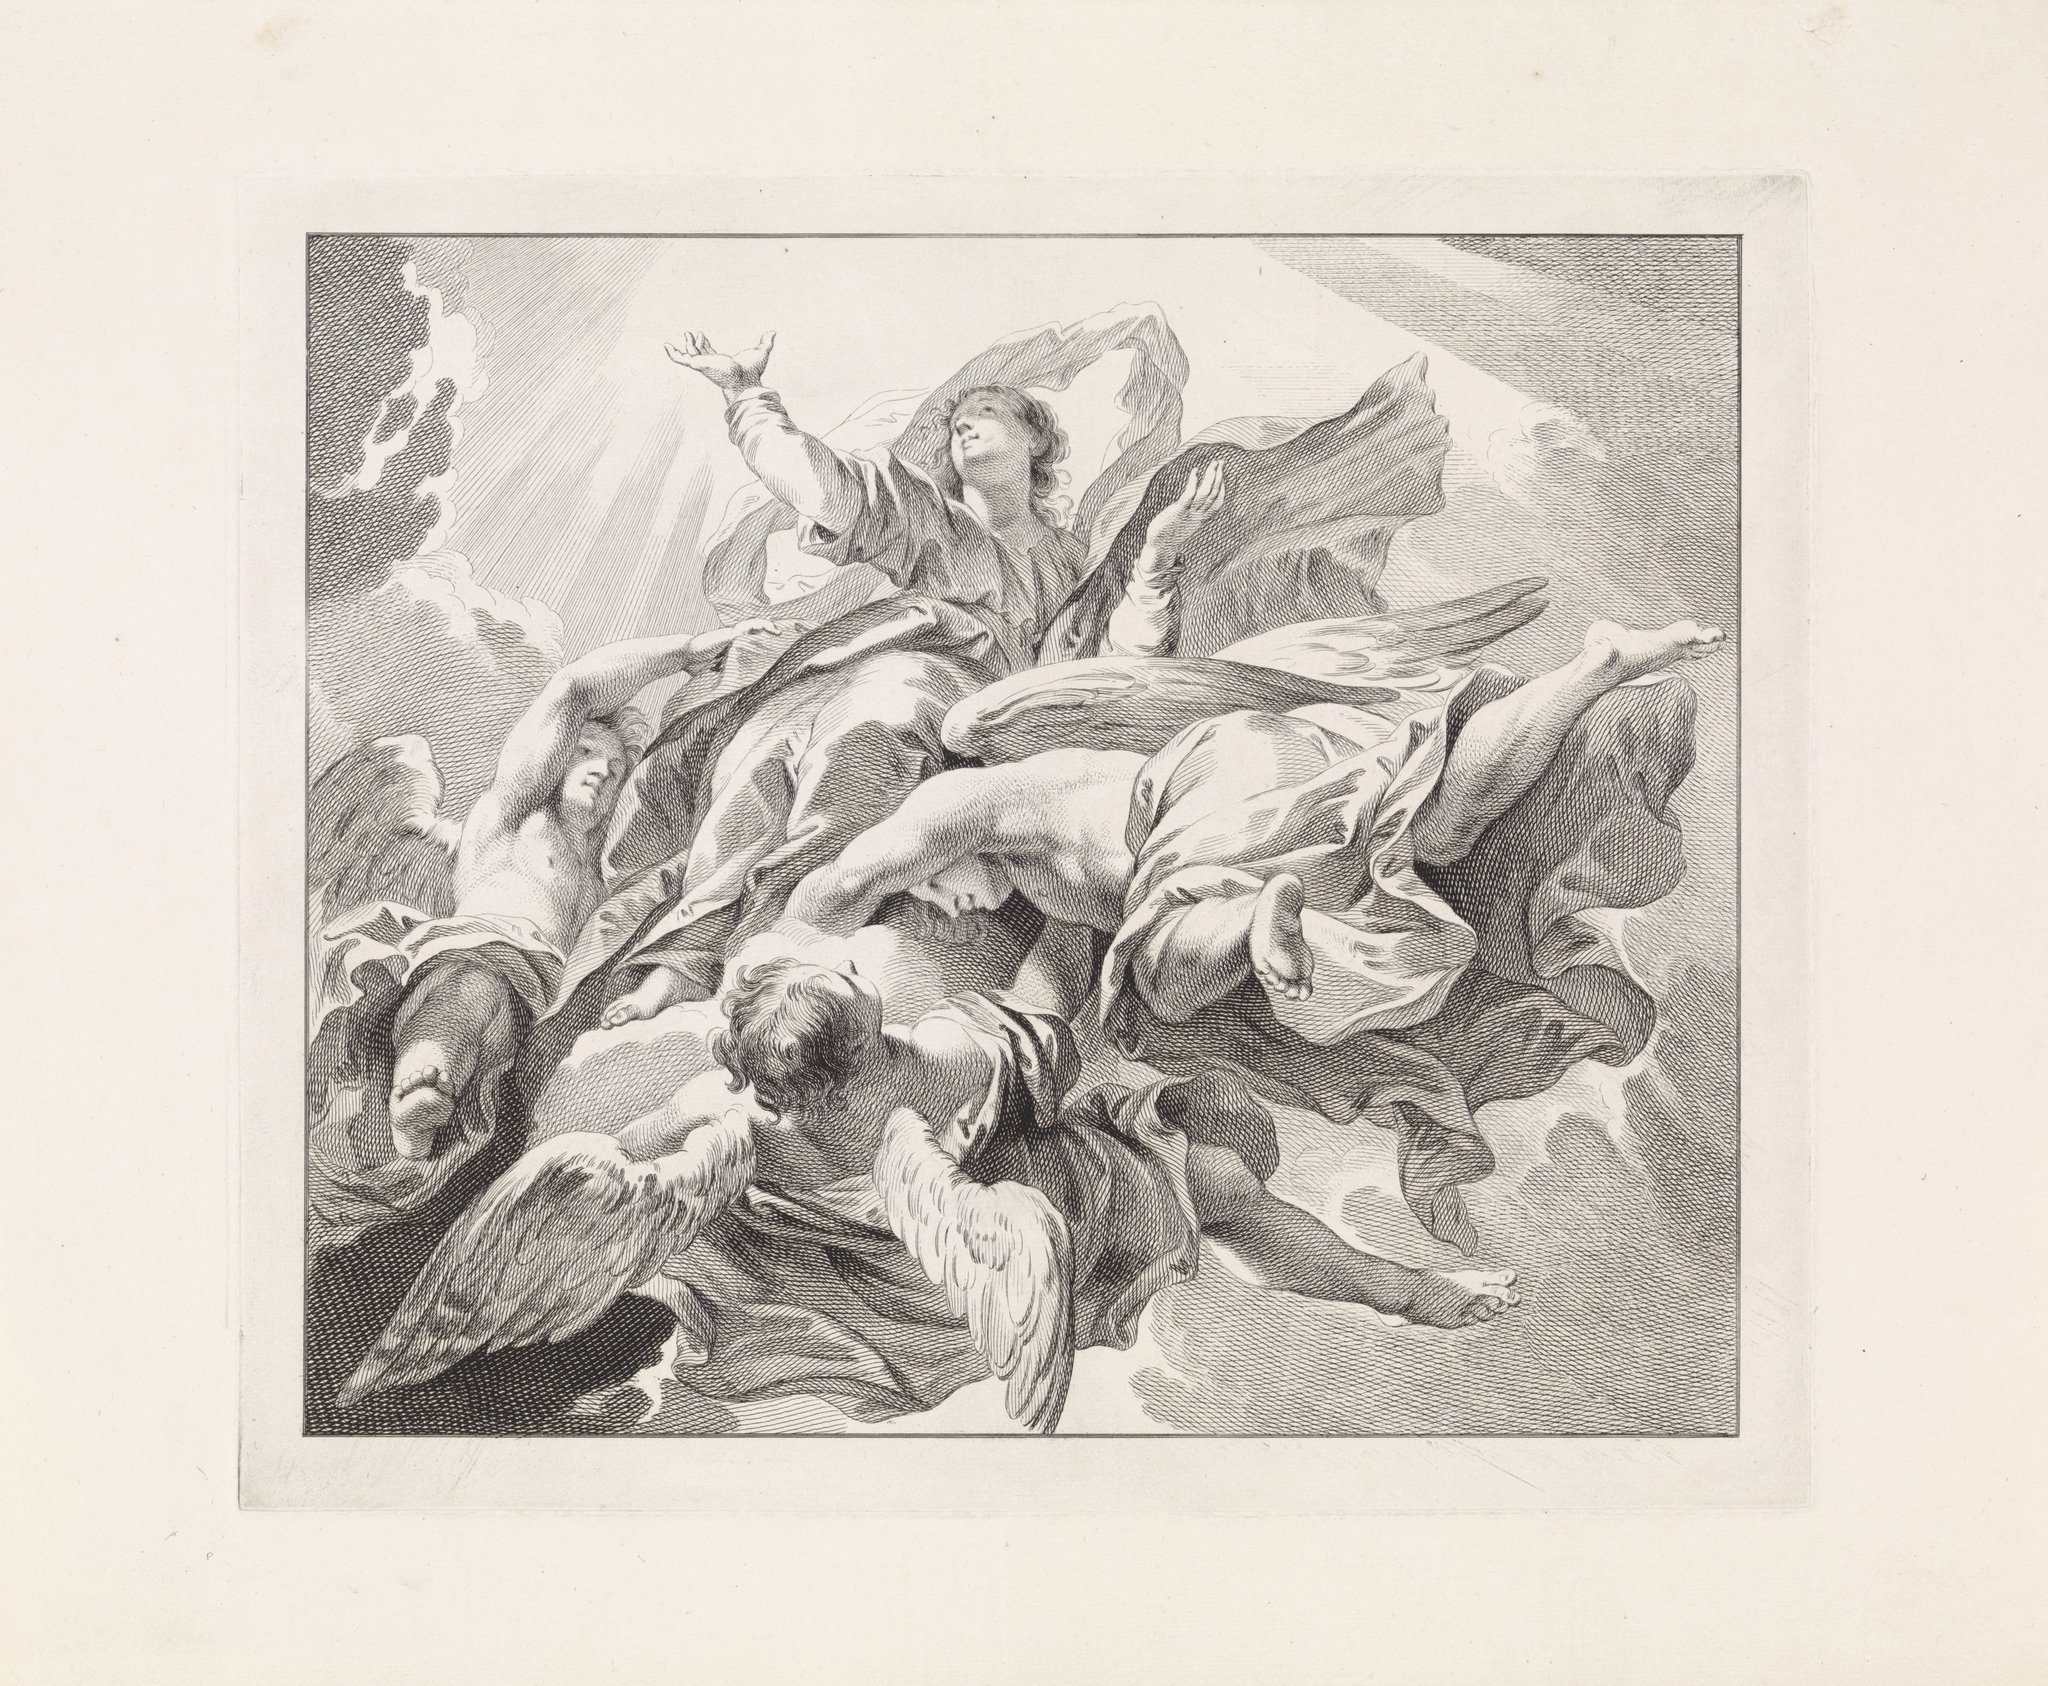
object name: print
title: Les plat-fonds ou les tableaux des galeries / De plafonds of gallerystukken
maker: jan punt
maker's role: draughtsman, print maker, publisher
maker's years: 1711-1779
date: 1750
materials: paper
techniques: engraving, etching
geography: amsterdam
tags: the assumption of mary ('assumptio corporis'): she is borne into heaven by angels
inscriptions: collector's mark: Lugt 240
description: Maria wordt door engelen ten hemel gevoerd.